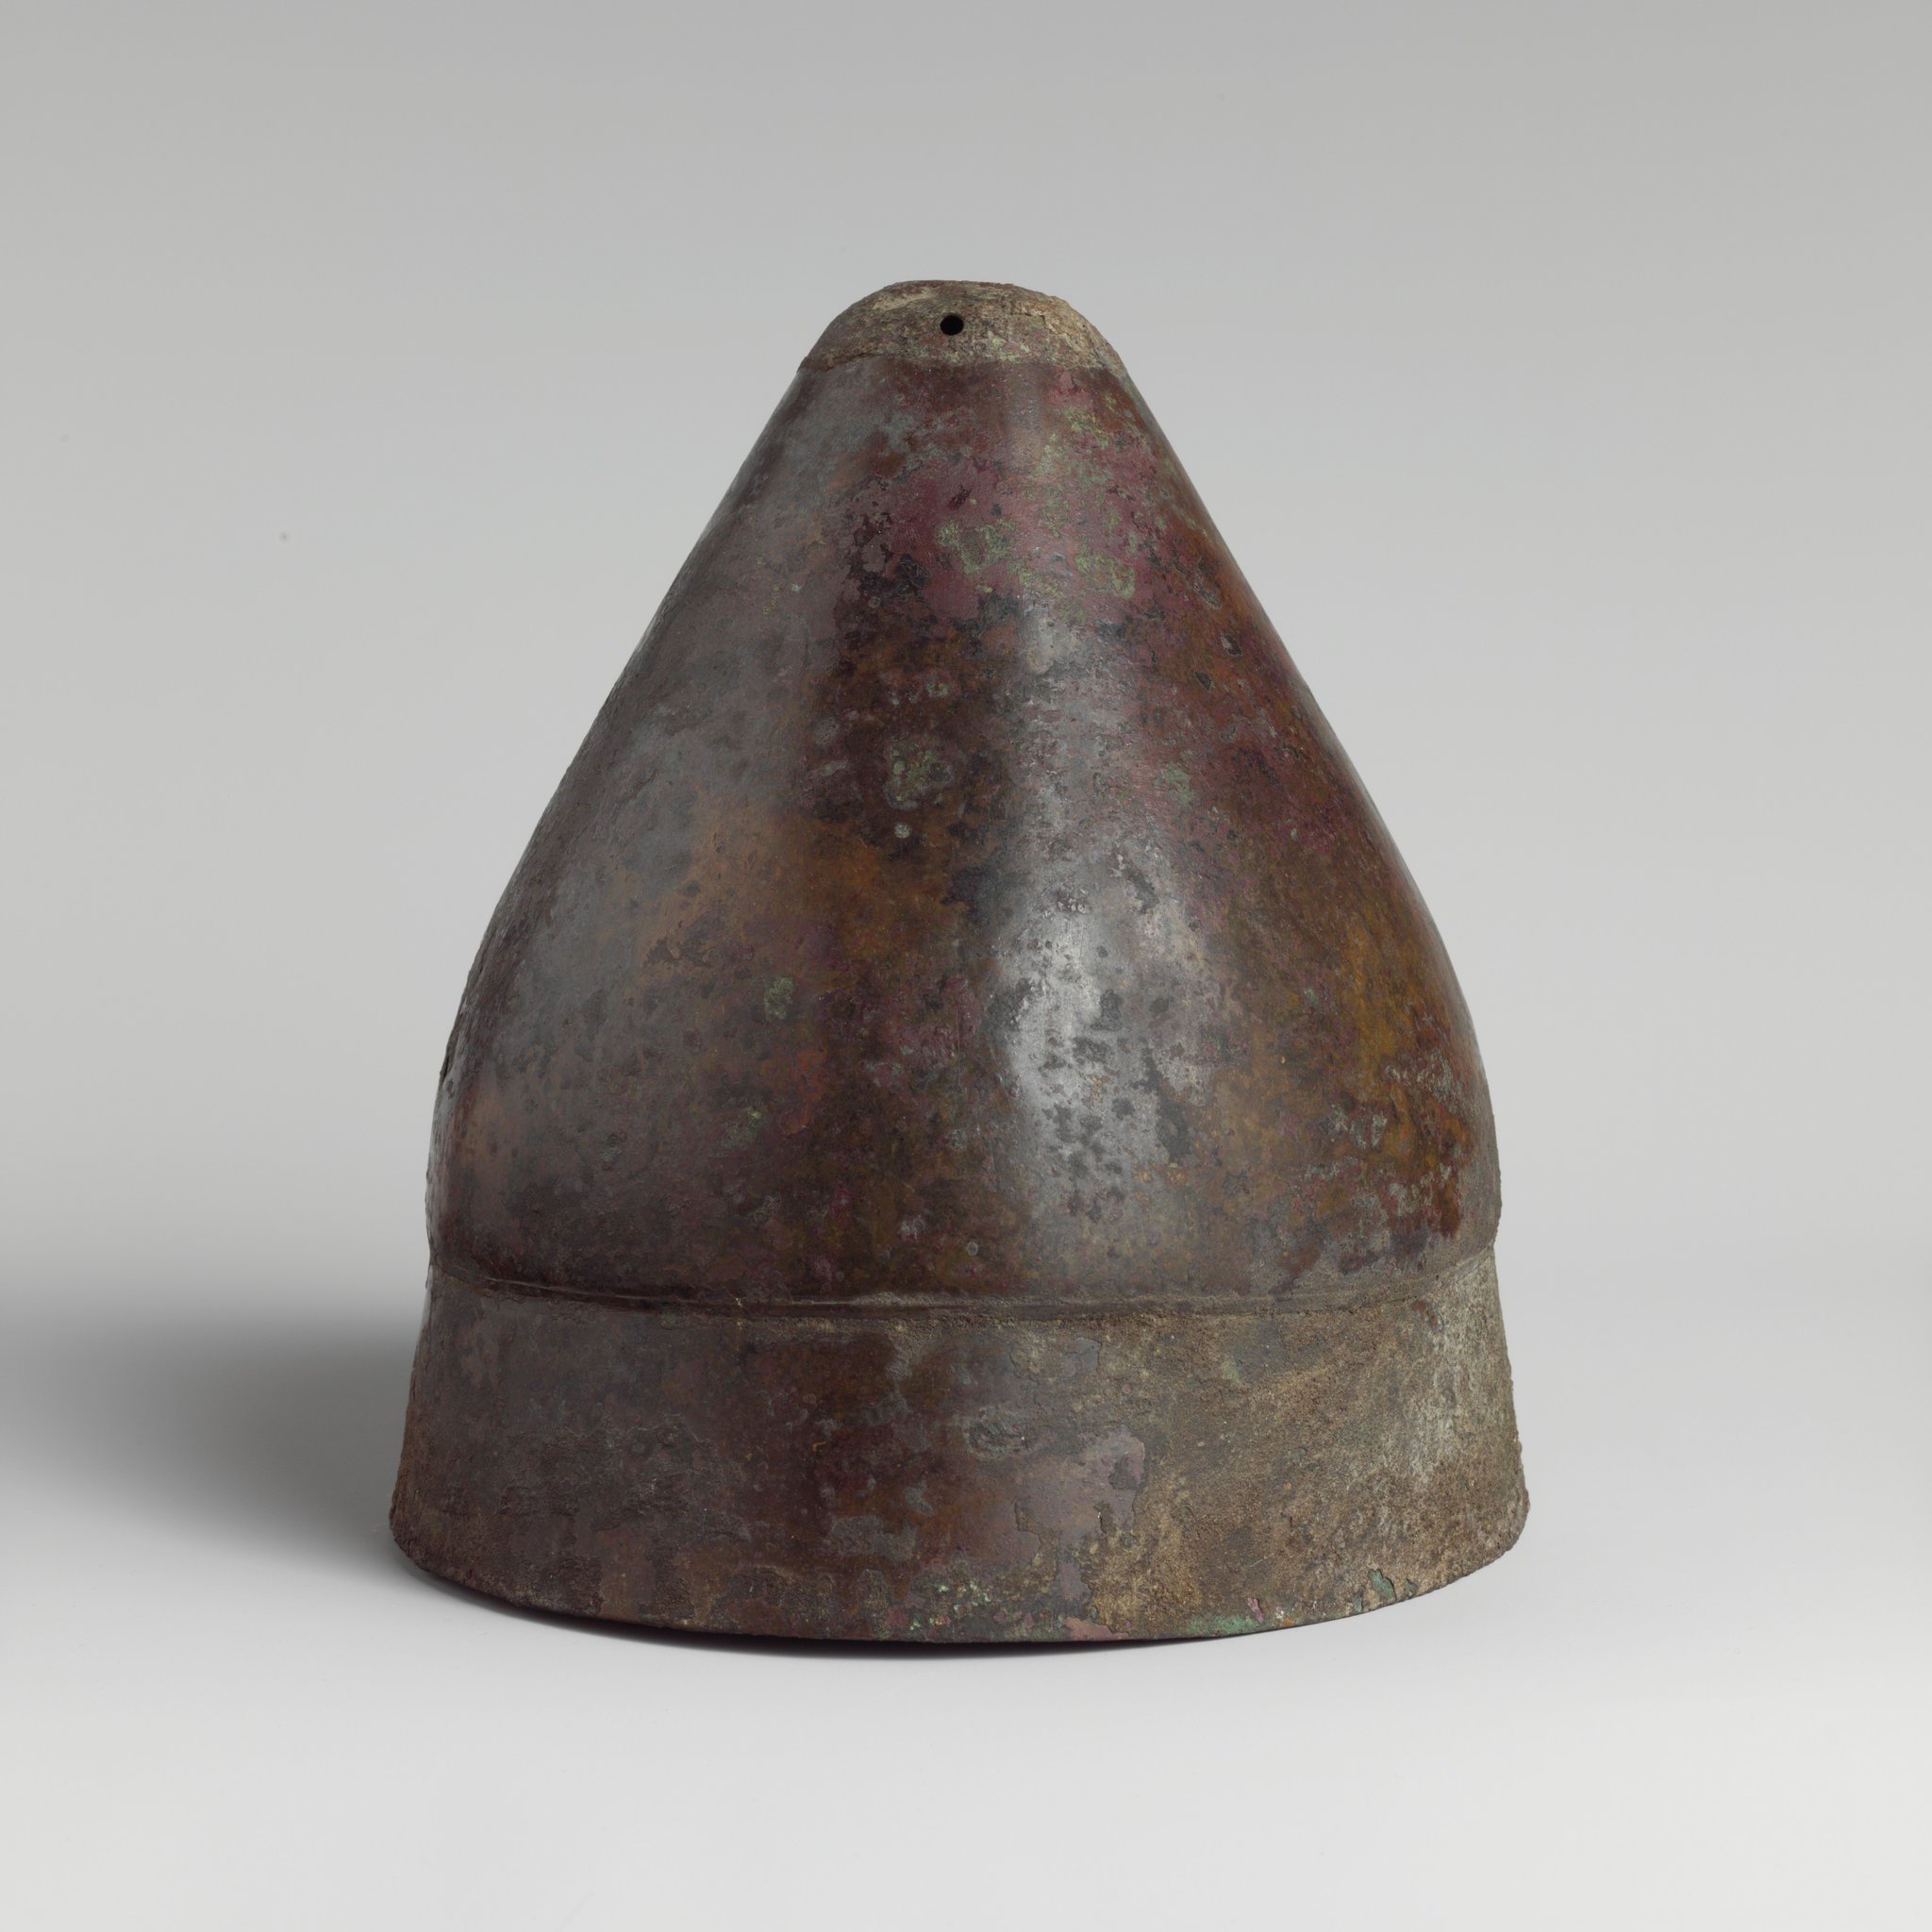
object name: helmet of conical shape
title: Bronze pilos (helmet of conical shape)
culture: greek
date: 401-500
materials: bronze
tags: helmets